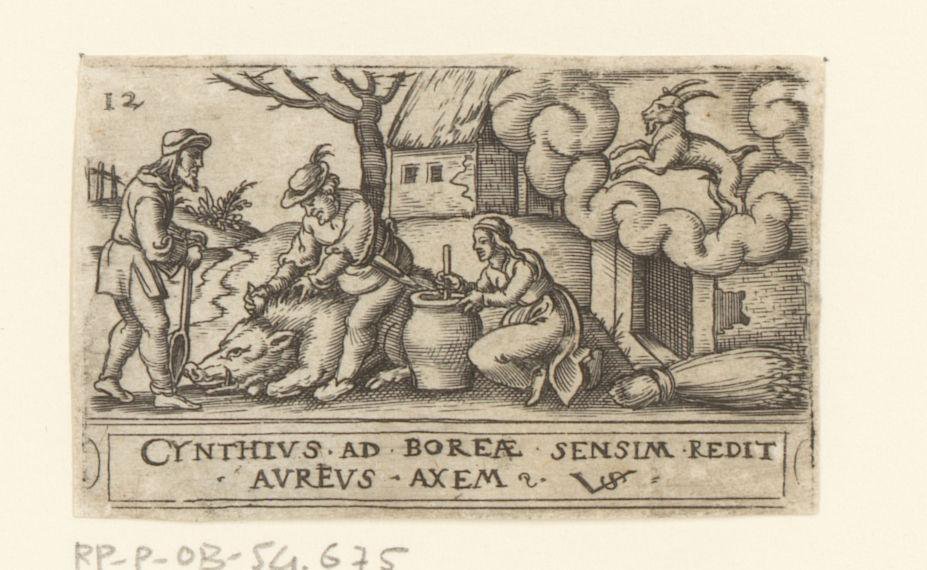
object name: print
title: December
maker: virgilius solis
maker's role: draughtsman, print maker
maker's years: 1514-1562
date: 1524-1562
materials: paper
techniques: engraving, etching, intaglio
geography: nuremberg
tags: december and its 'labours', capricorn (zodiacal sign of december)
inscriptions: number: ‘57’, collector's mark: Lugt 2228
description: Maakt deel uit van een serie van twaalf prenten met verbeeldingen van de twaalf maanden. In de collectie Rijksmuseum bevinden zich negen van de twaalf originele prenten en de overige drie in kopie.